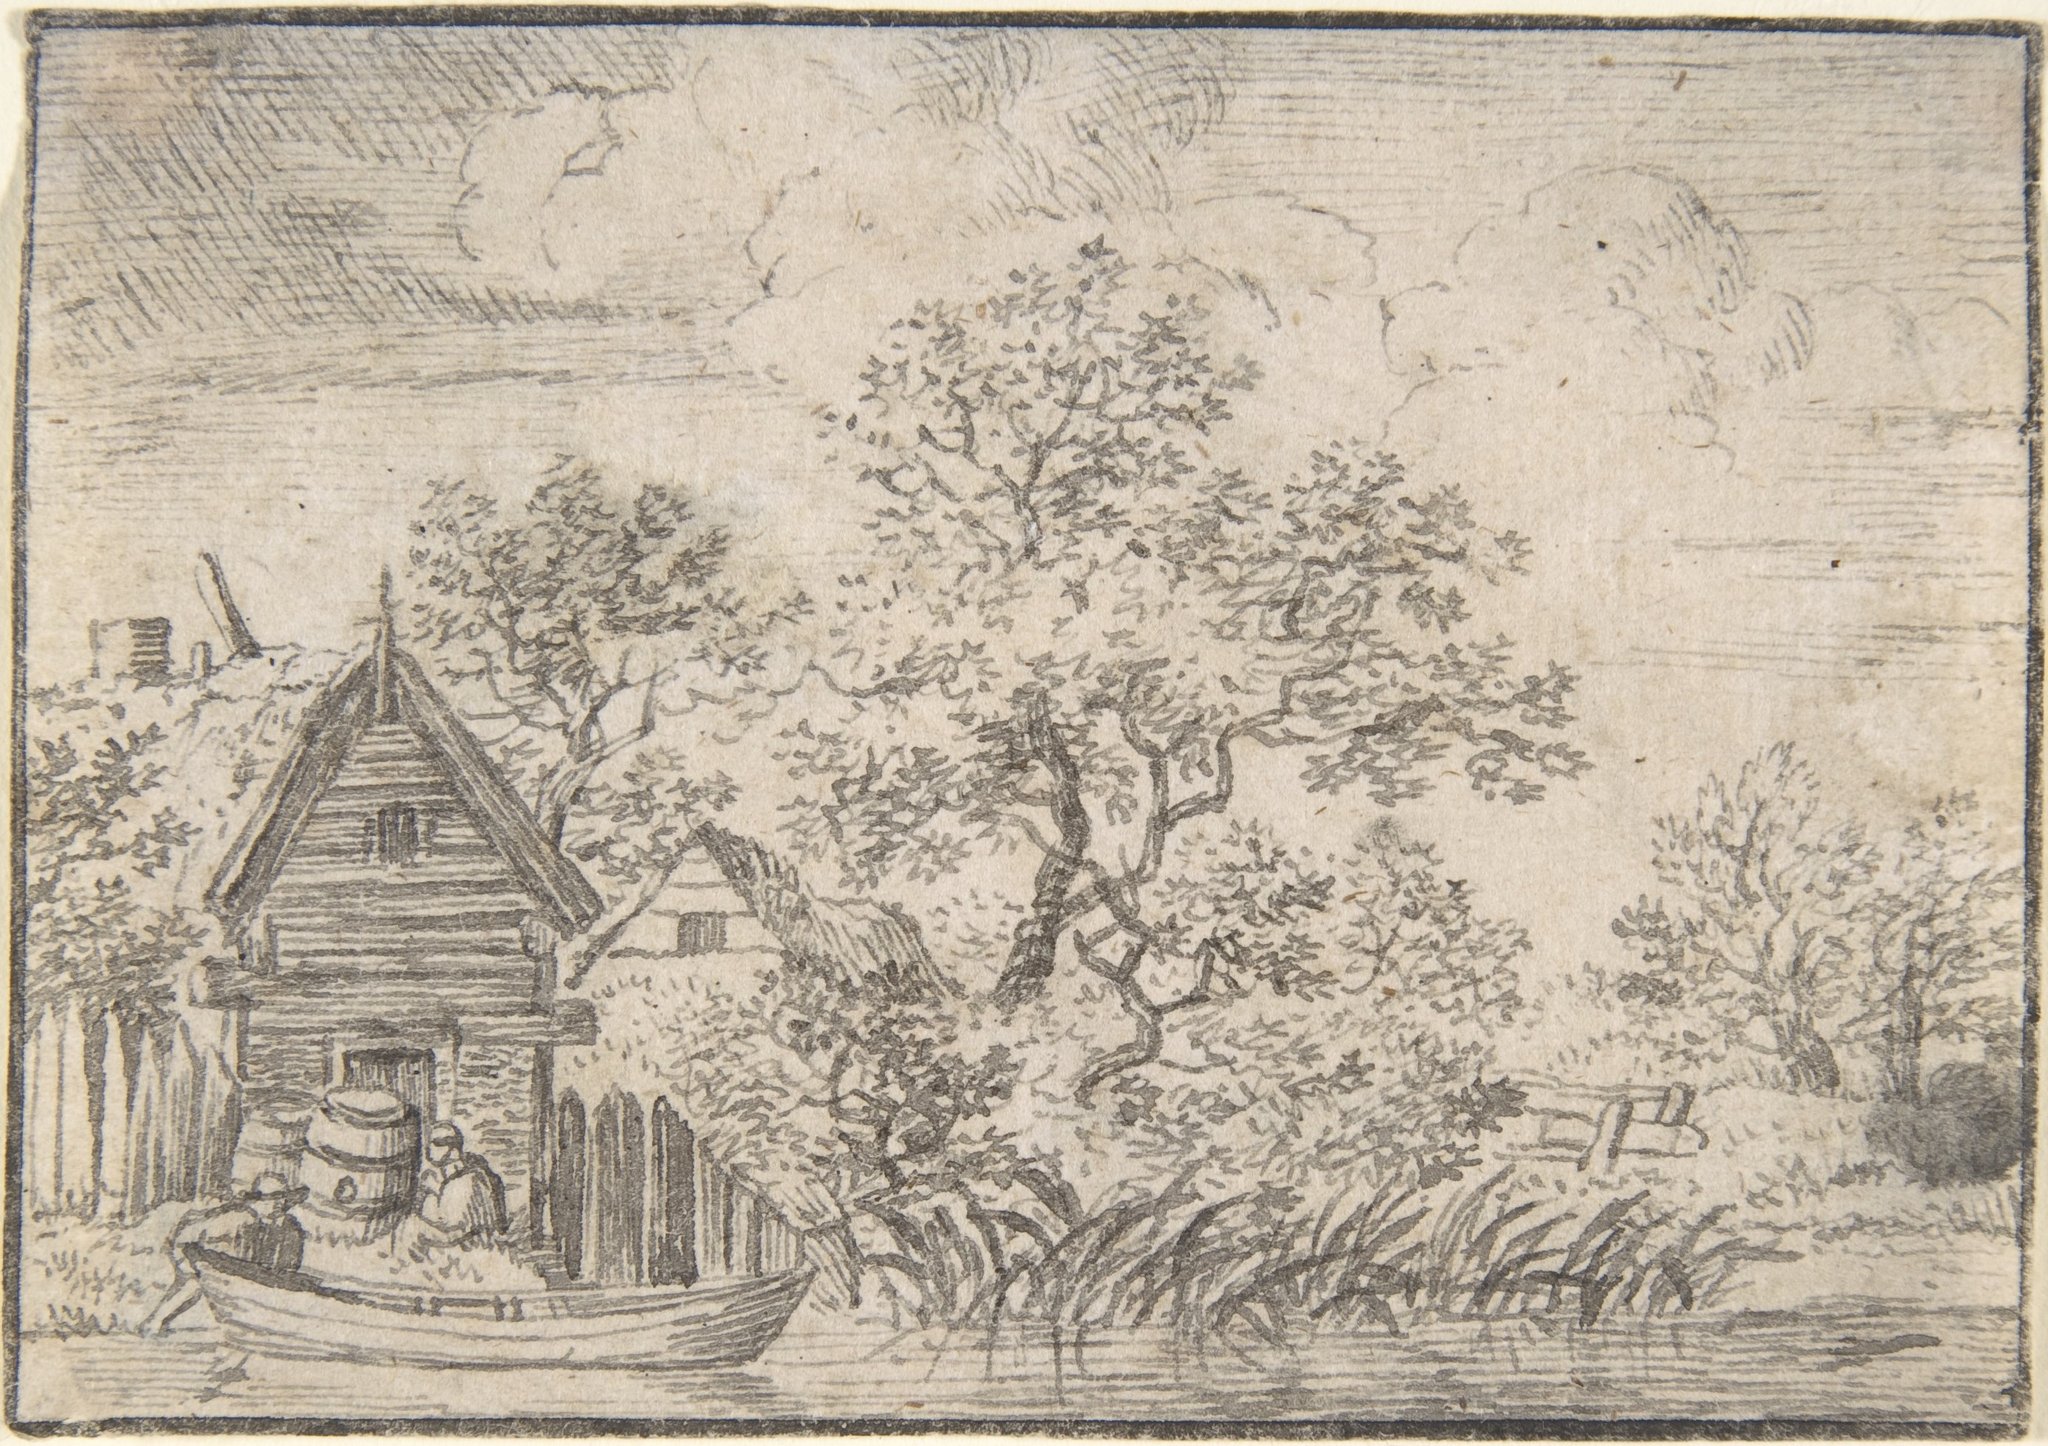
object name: drawing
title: Two Men and a Boat by a House on the Water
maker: anonymous, dutch, 17th century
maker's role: artist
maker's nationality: dutch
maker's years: 1600-1700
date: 1601-1700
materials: ink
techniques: pen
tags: houses,landscapes,boats